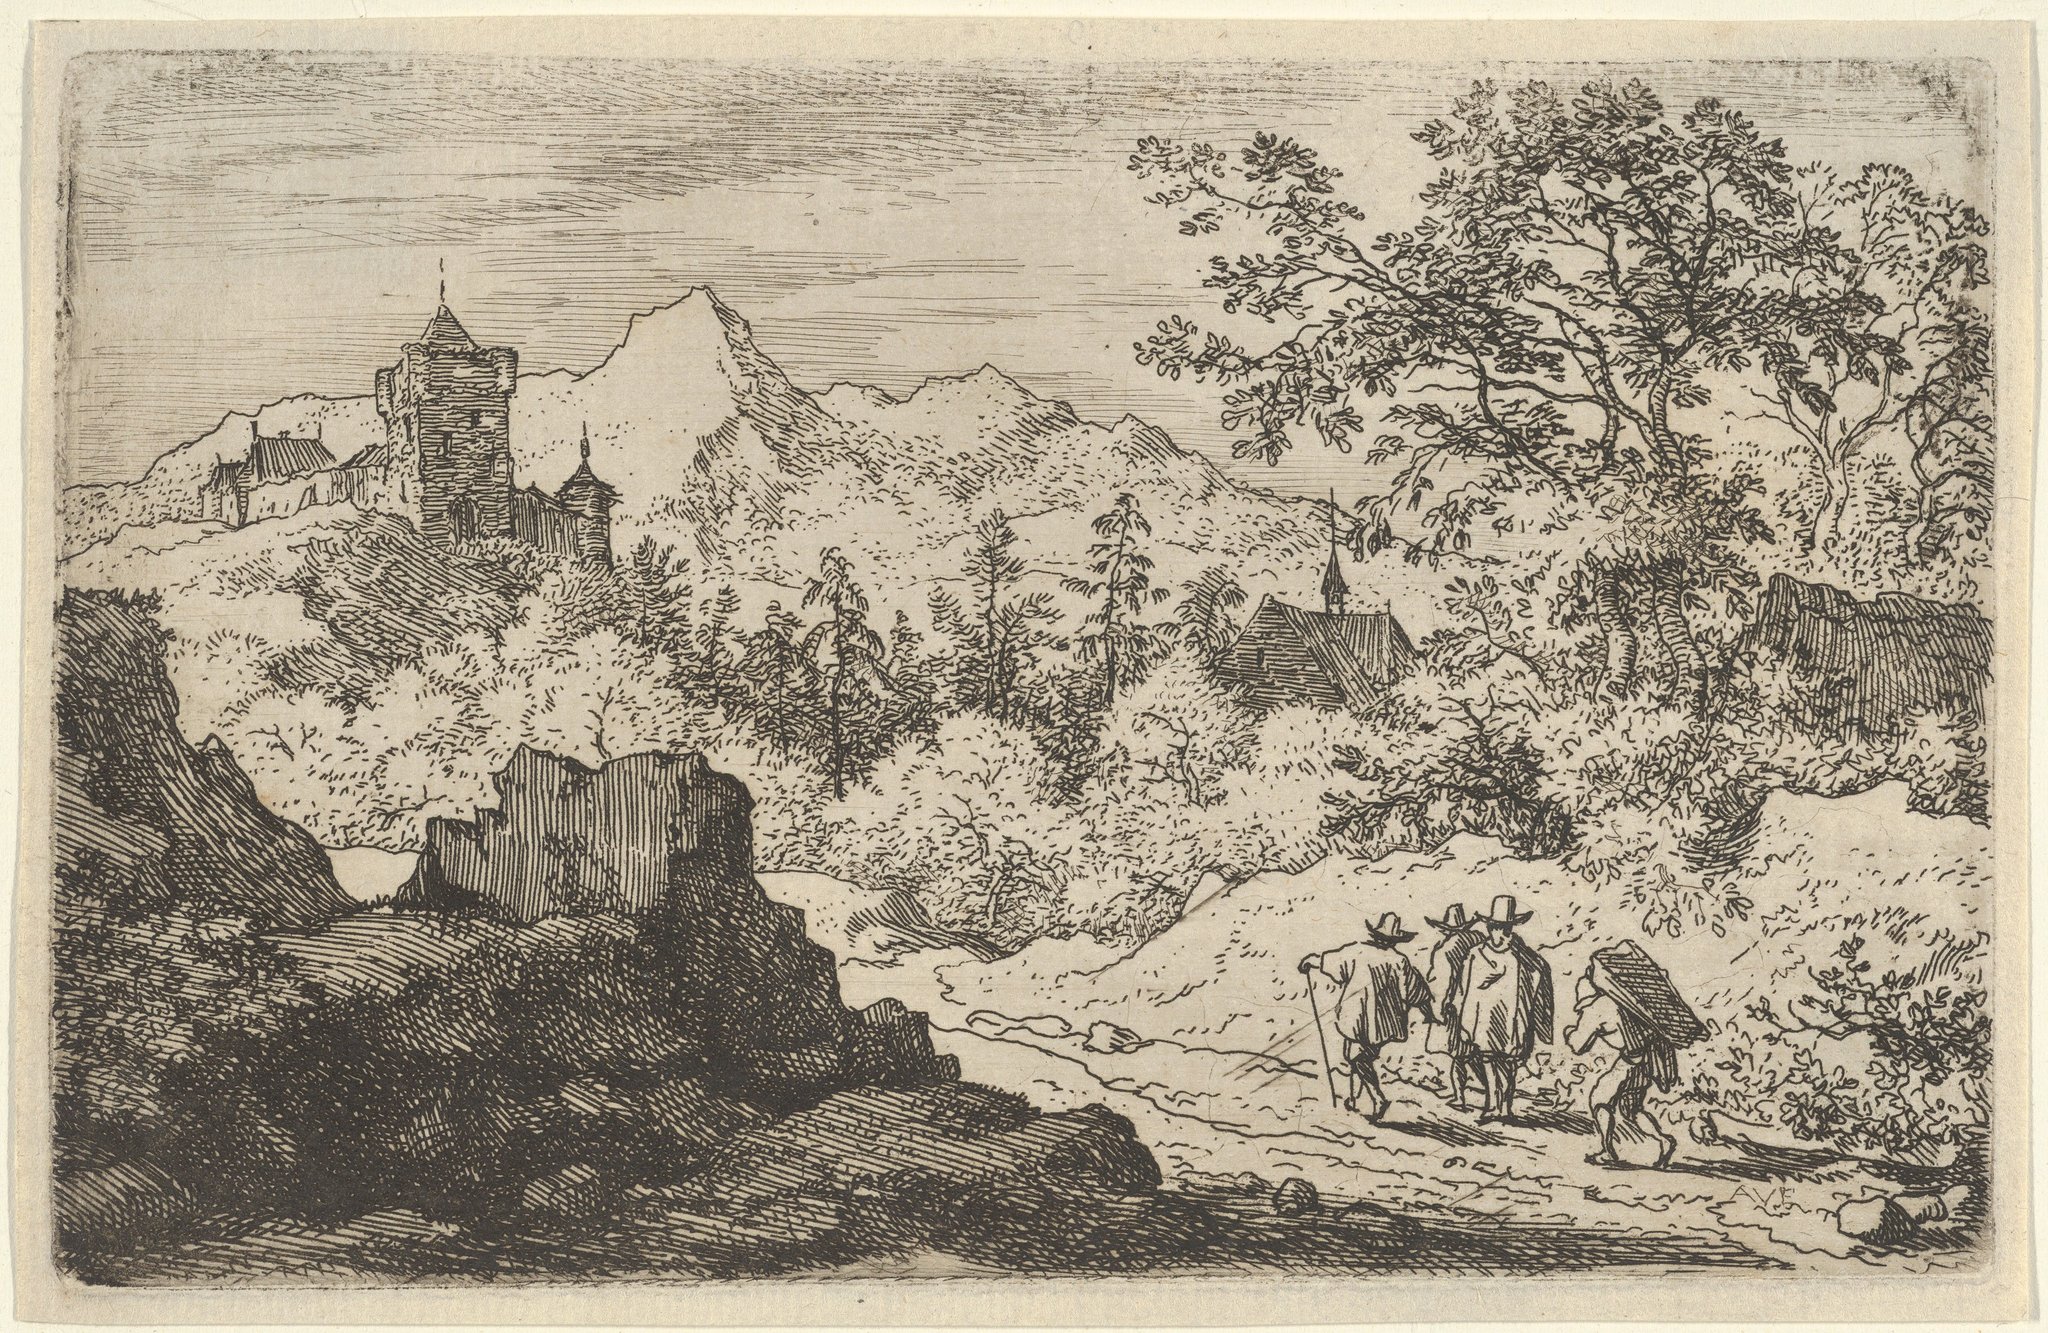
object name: print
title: The Three Men and the Porter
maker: allart van everdingen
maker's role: artist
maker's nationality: dutch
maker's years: 1621-1675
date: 1621-1675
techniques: engraving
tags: buildings,men,hills,trees